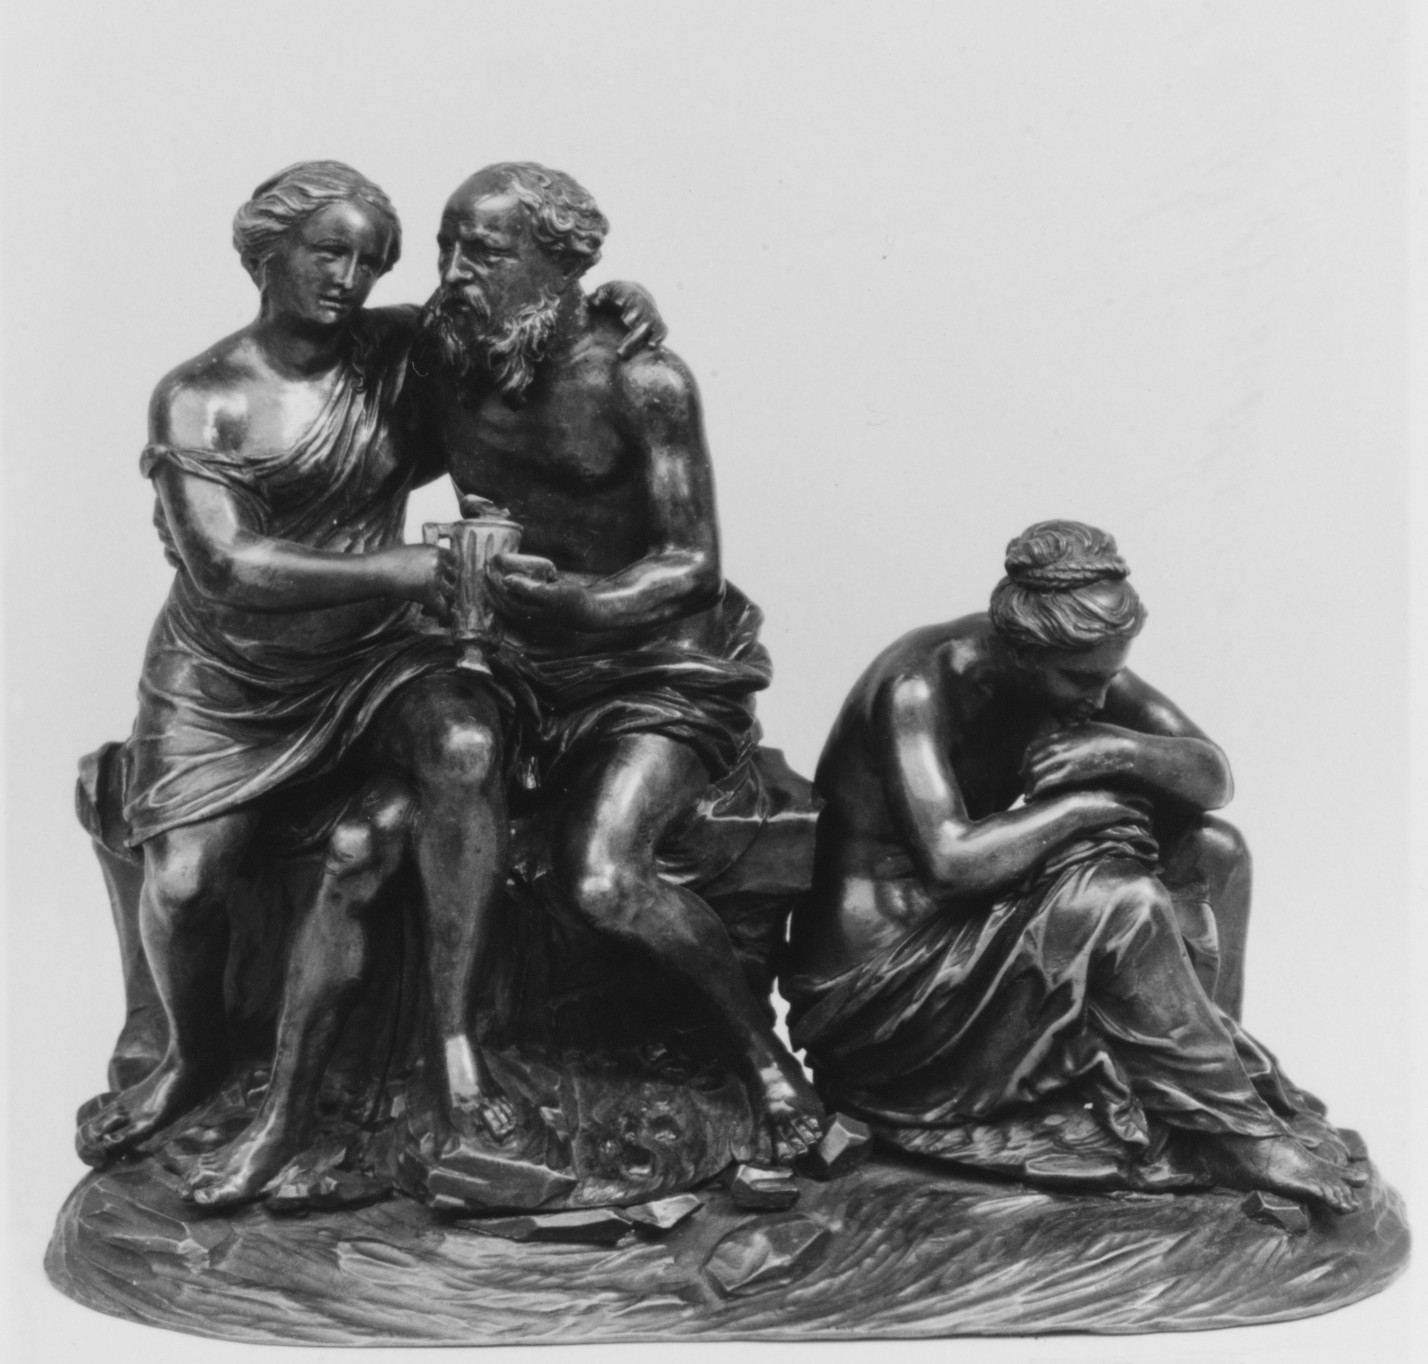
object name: statuette group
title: Lot and his Daughters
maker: leonhard kern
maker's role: artist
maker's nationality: german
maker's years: 1588-1662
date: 1601-1700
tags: men,women